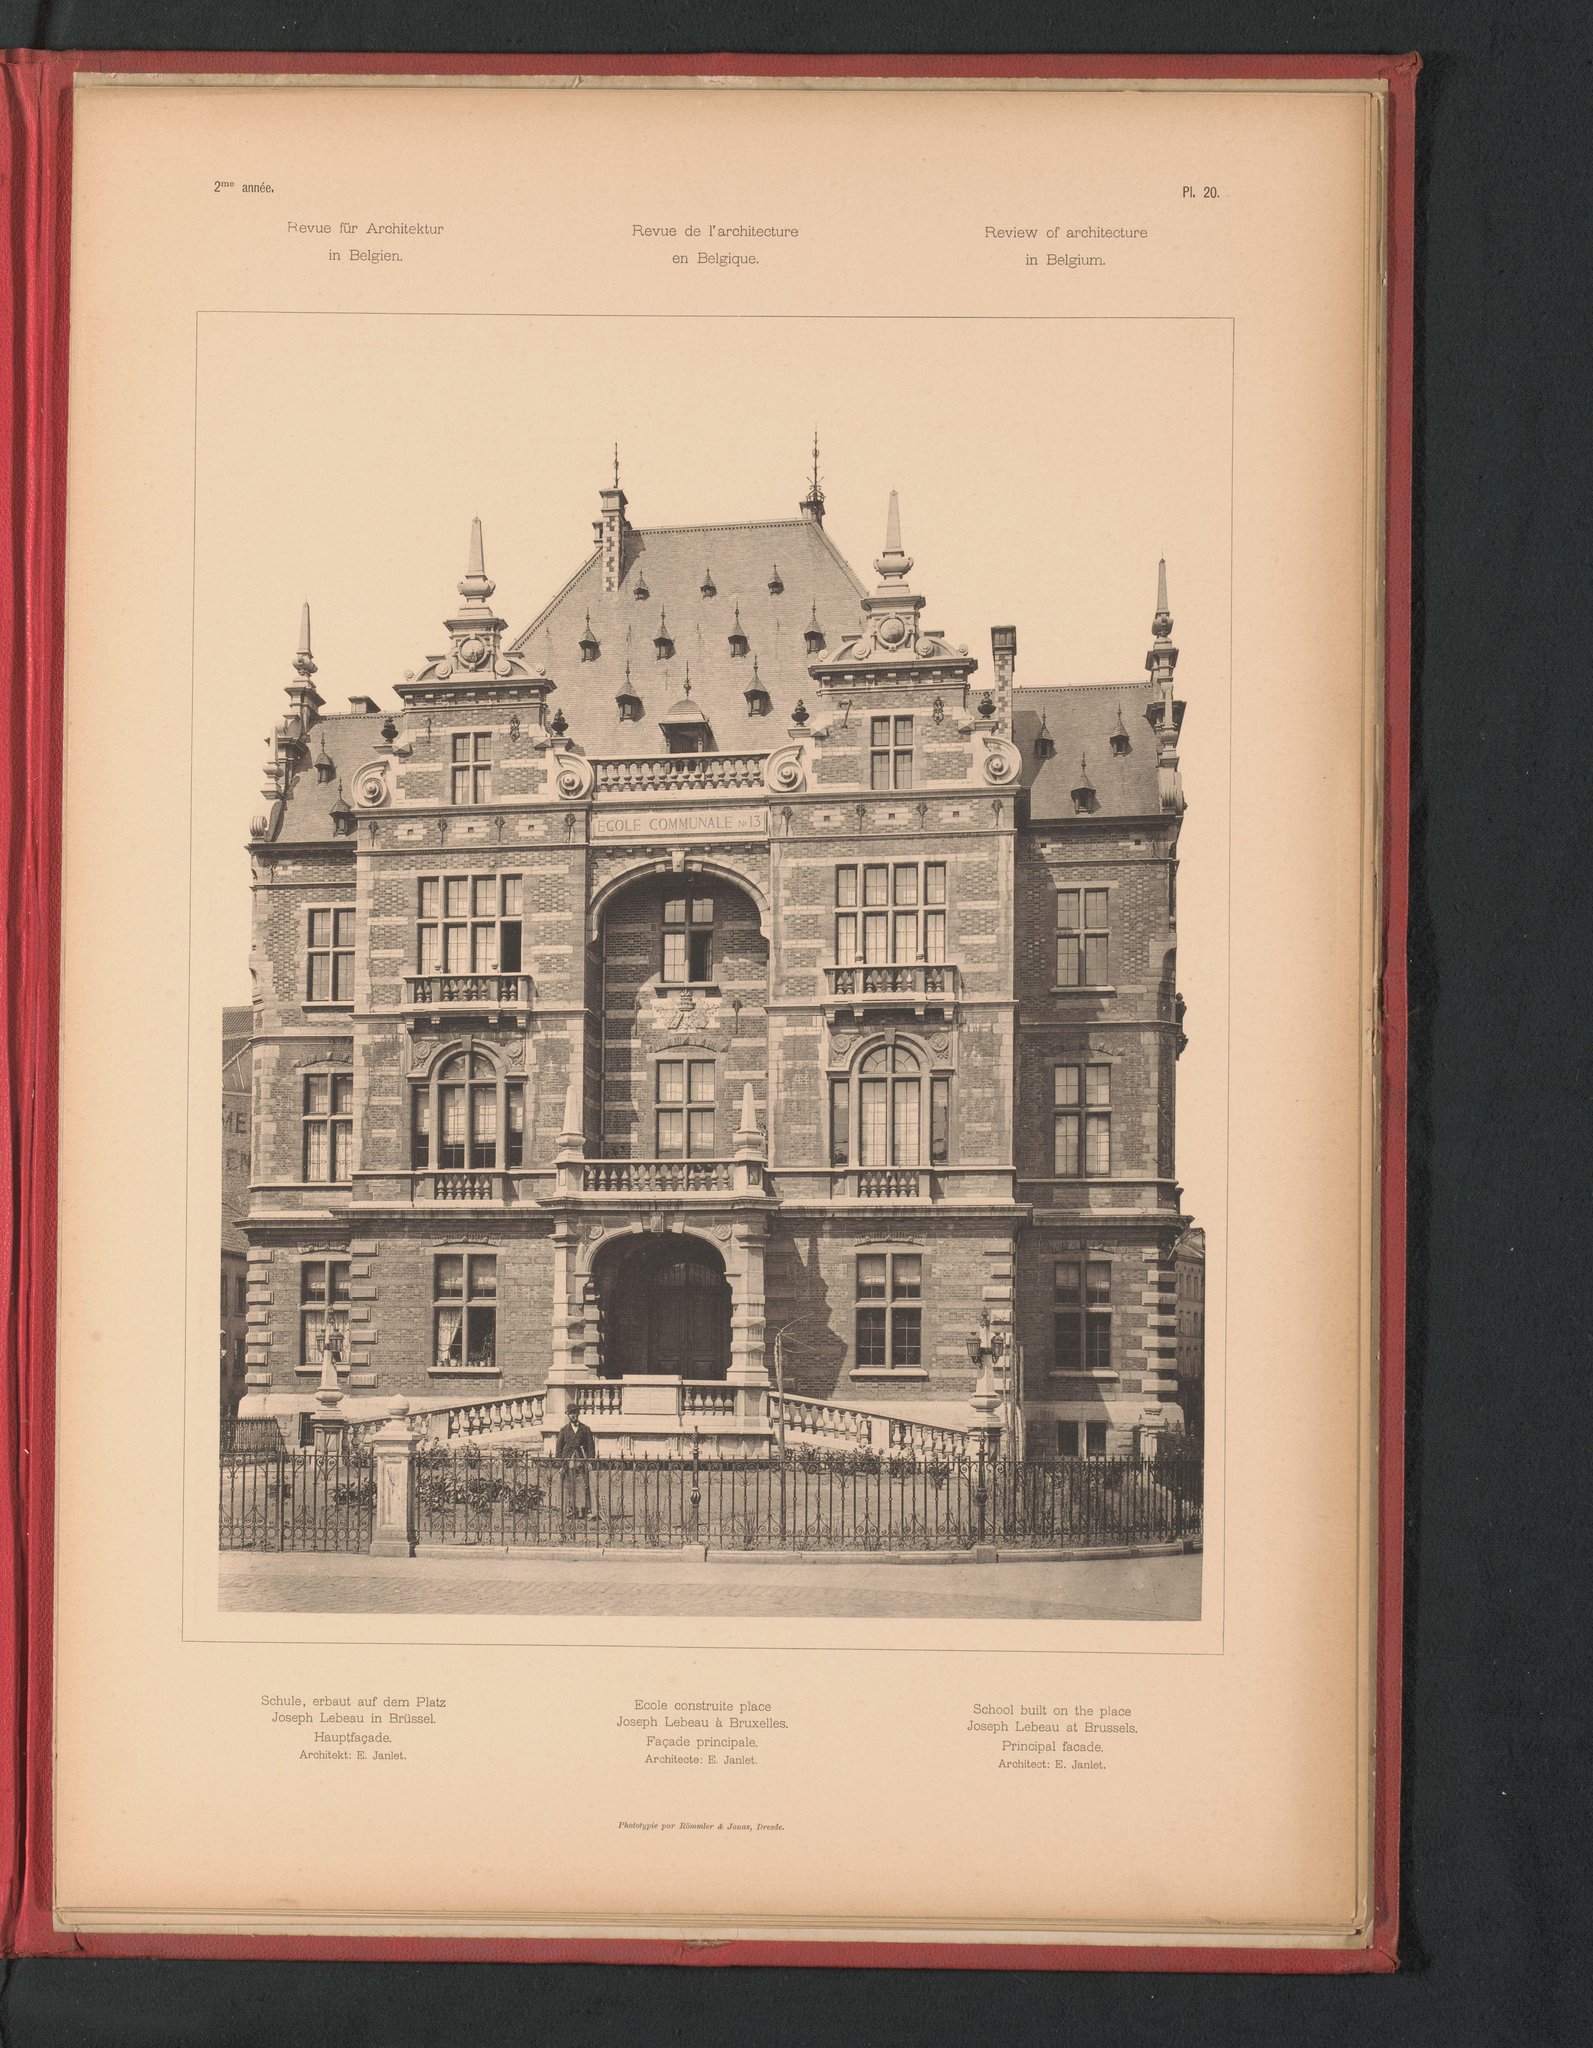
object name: photomechanical print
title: Schule, erbaut auf dem Platz Joseph Lebeau in Brüssel. Hauptfaçade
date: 1888-1893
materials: paper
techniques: photograph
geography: dresden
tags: housing, brussels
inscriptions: inscription: ‘Architecte: E. Janlet.’, inscription: ‘Architekt: E. Janlet.’, number: ‘Pl. 20.’, inscription: ‘2me année.’, inscription: ‘Architect: E. Janlet.’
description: Deze prent maakt deel uit van een omslag met 110 prenten op 90 bladen en 18 tekstbladen.